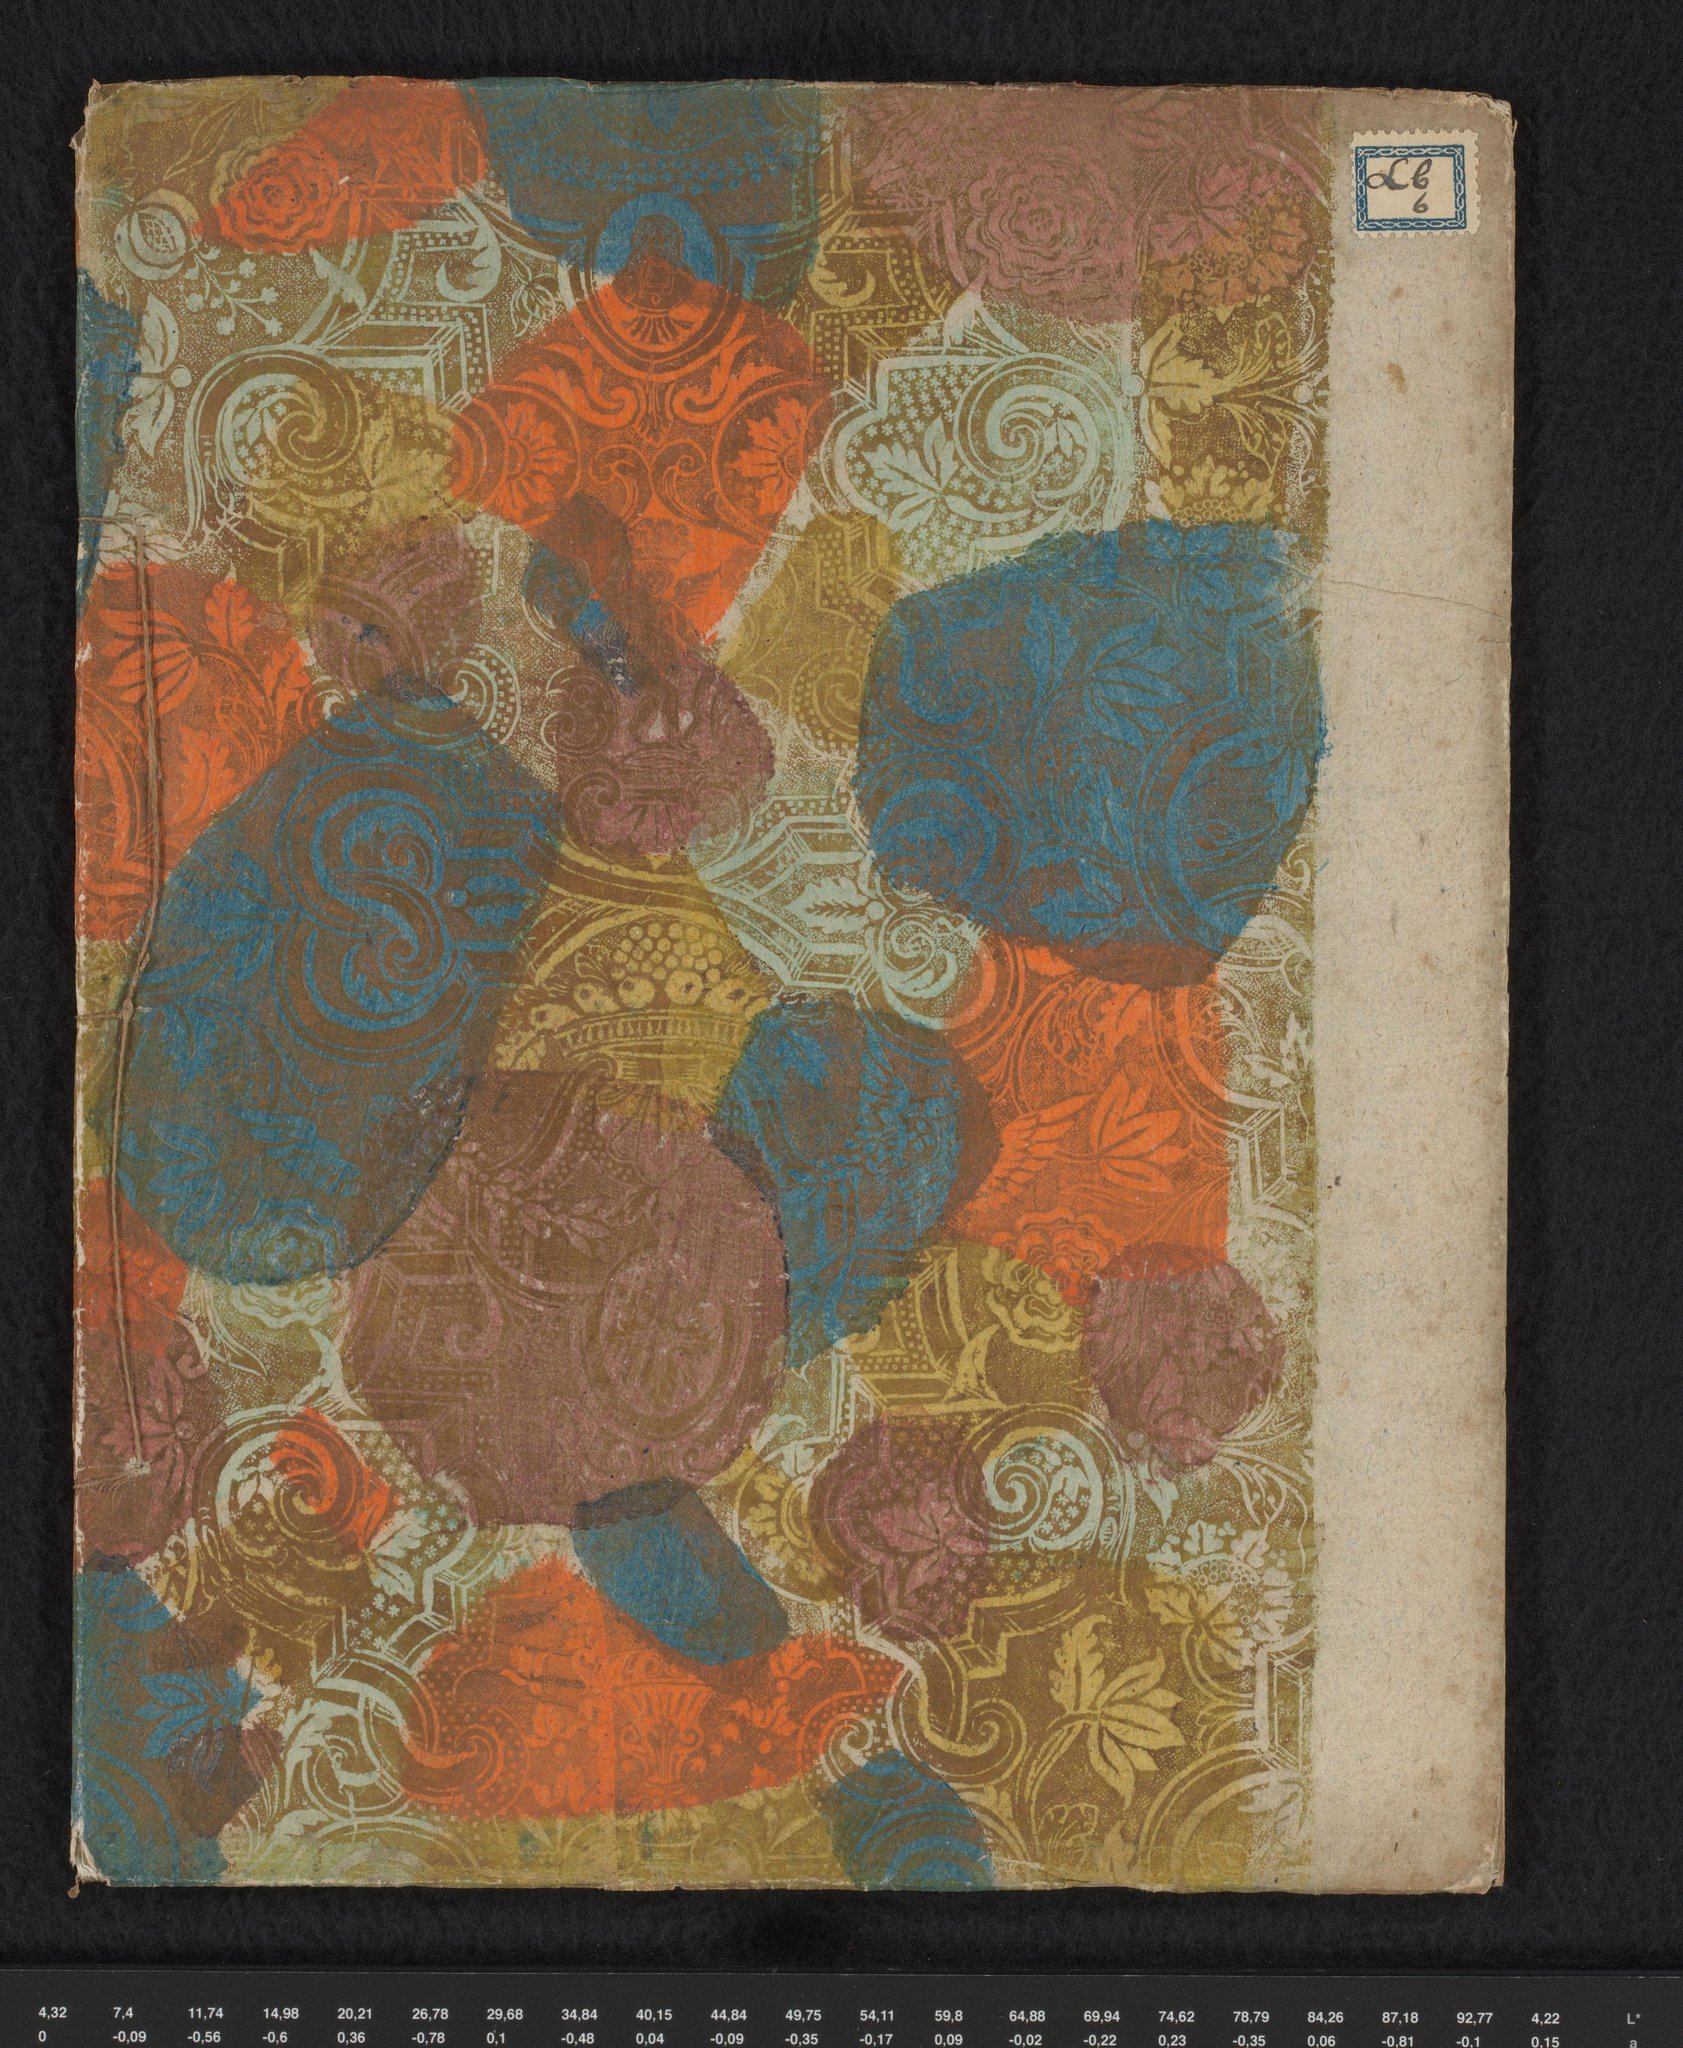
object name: book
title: Disputatio juridica inauguralis de societate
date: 1788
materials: gold leaf, paint, paper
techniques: letterpress printing, relief print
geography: netherlands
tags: utrecht, hendrik constans swellengrebel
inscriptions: label: ‘Lb 6’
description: Disputatio juridica inauguralis de societate. Proefschrift van Hendrik Constans Swellengrebel, Universiteit Utrecht 1785. Met voorin een allegorische voorstelling van de uitgever (gedateerd 1778). In omslag van goudbrokaatpapier met bloemen en ranken.